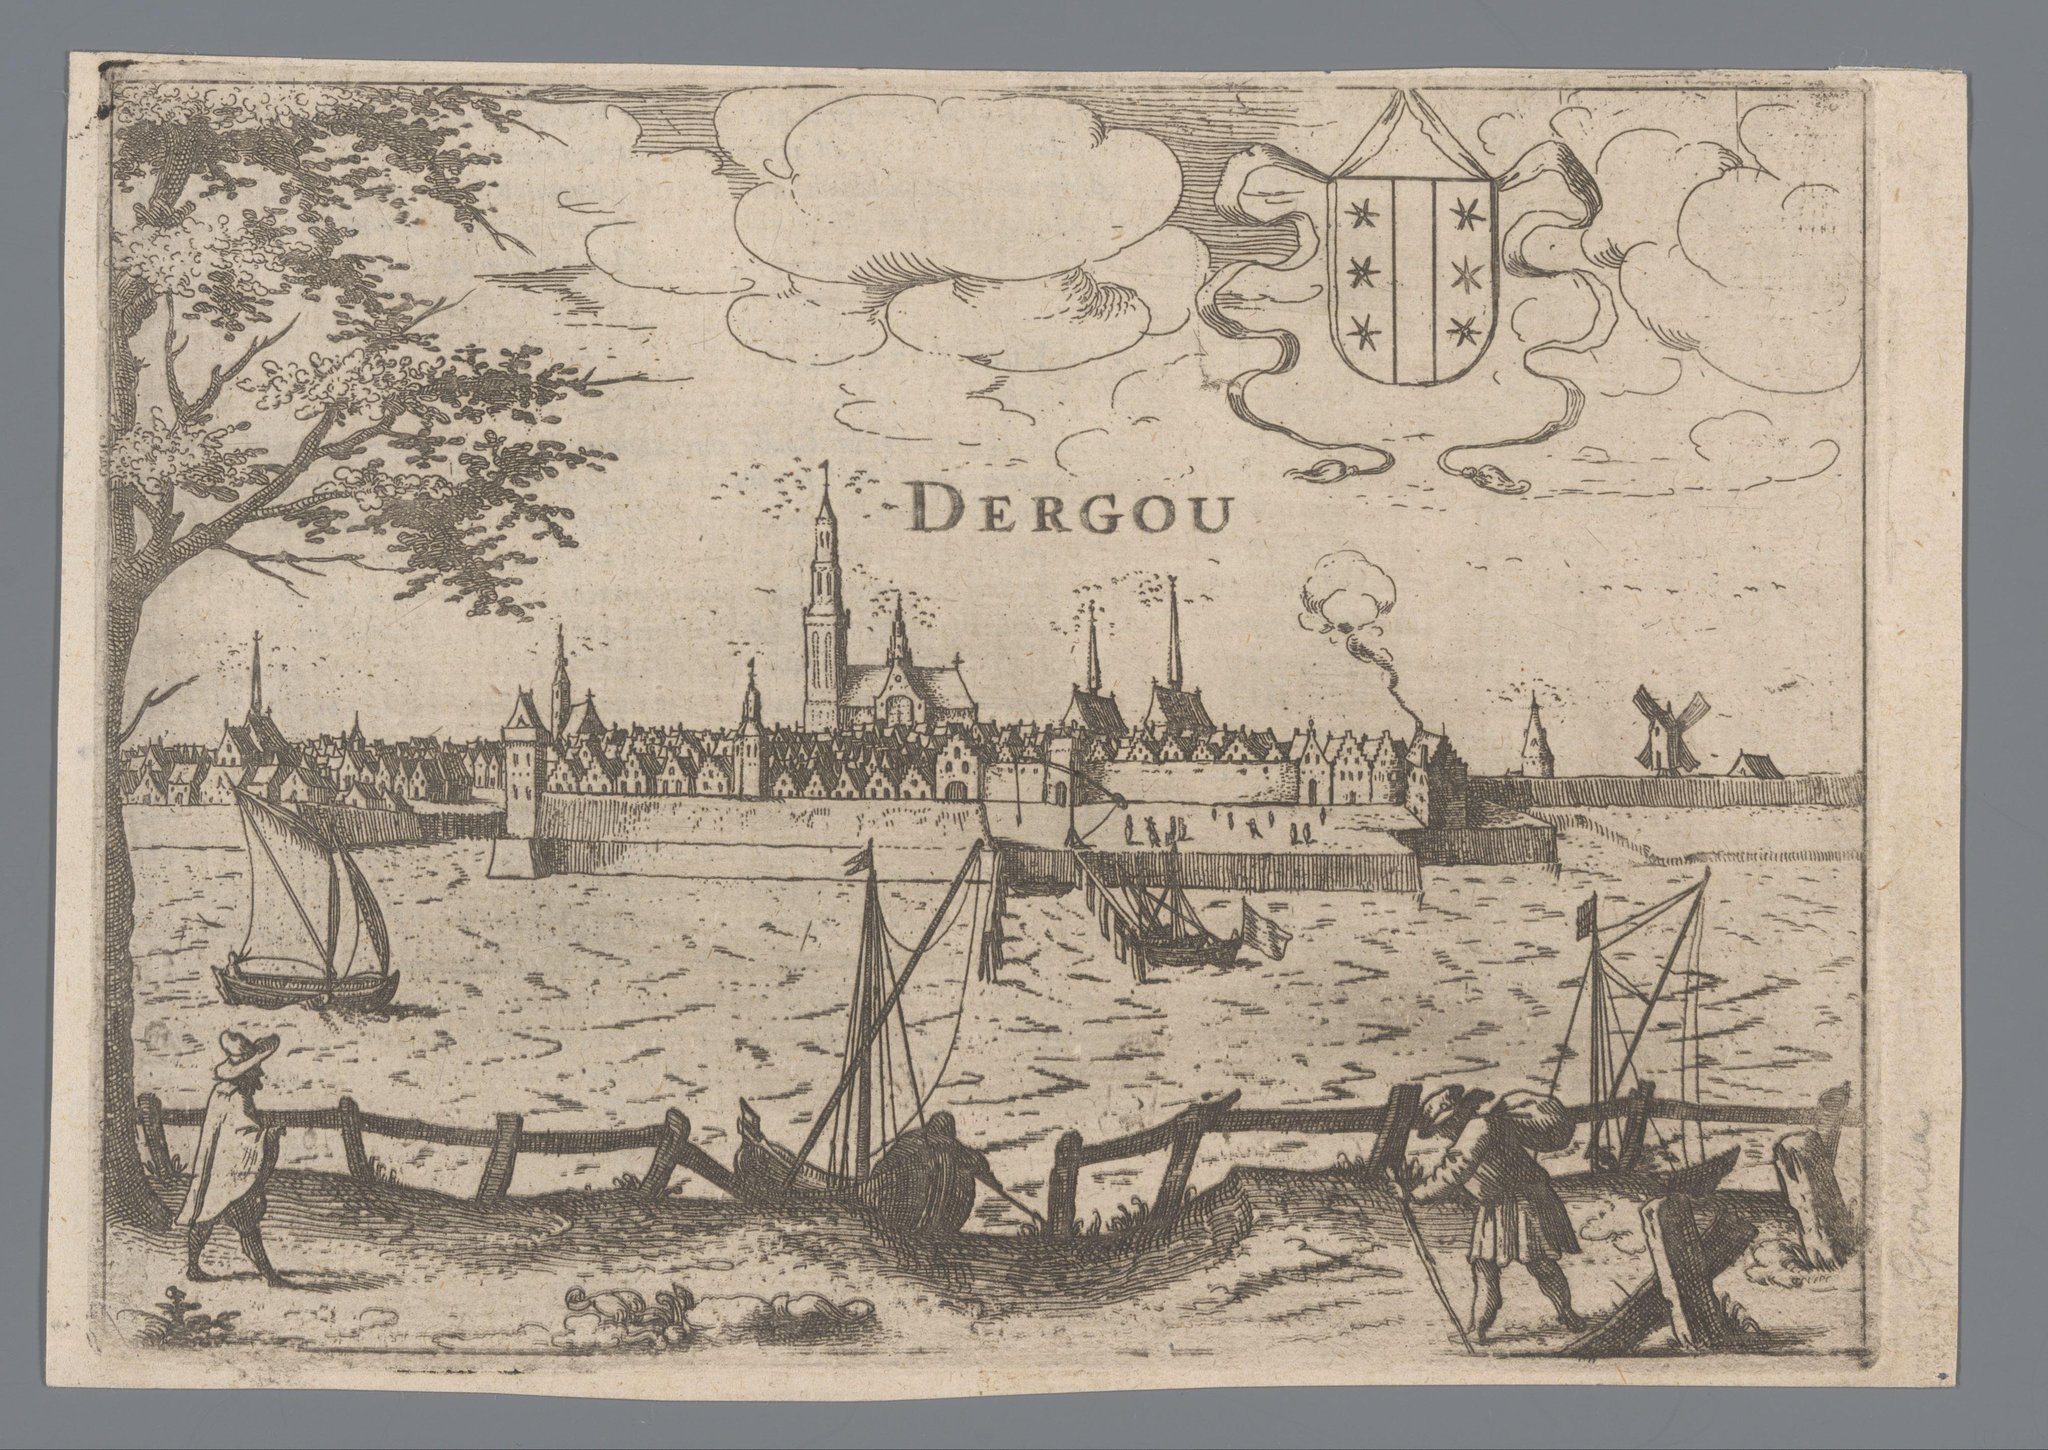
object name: print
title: Gezicht op Gouda vanaf de oever van de Gouwe of de Hollandse IJssel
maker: Anonymous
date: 1650-1700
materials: paper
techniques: etching, letterpress printing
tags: city-view, and landscape with man-made constructions, church (exterior), canals, waters (in city) (+ city(-scape) with figures, staffage), gouda